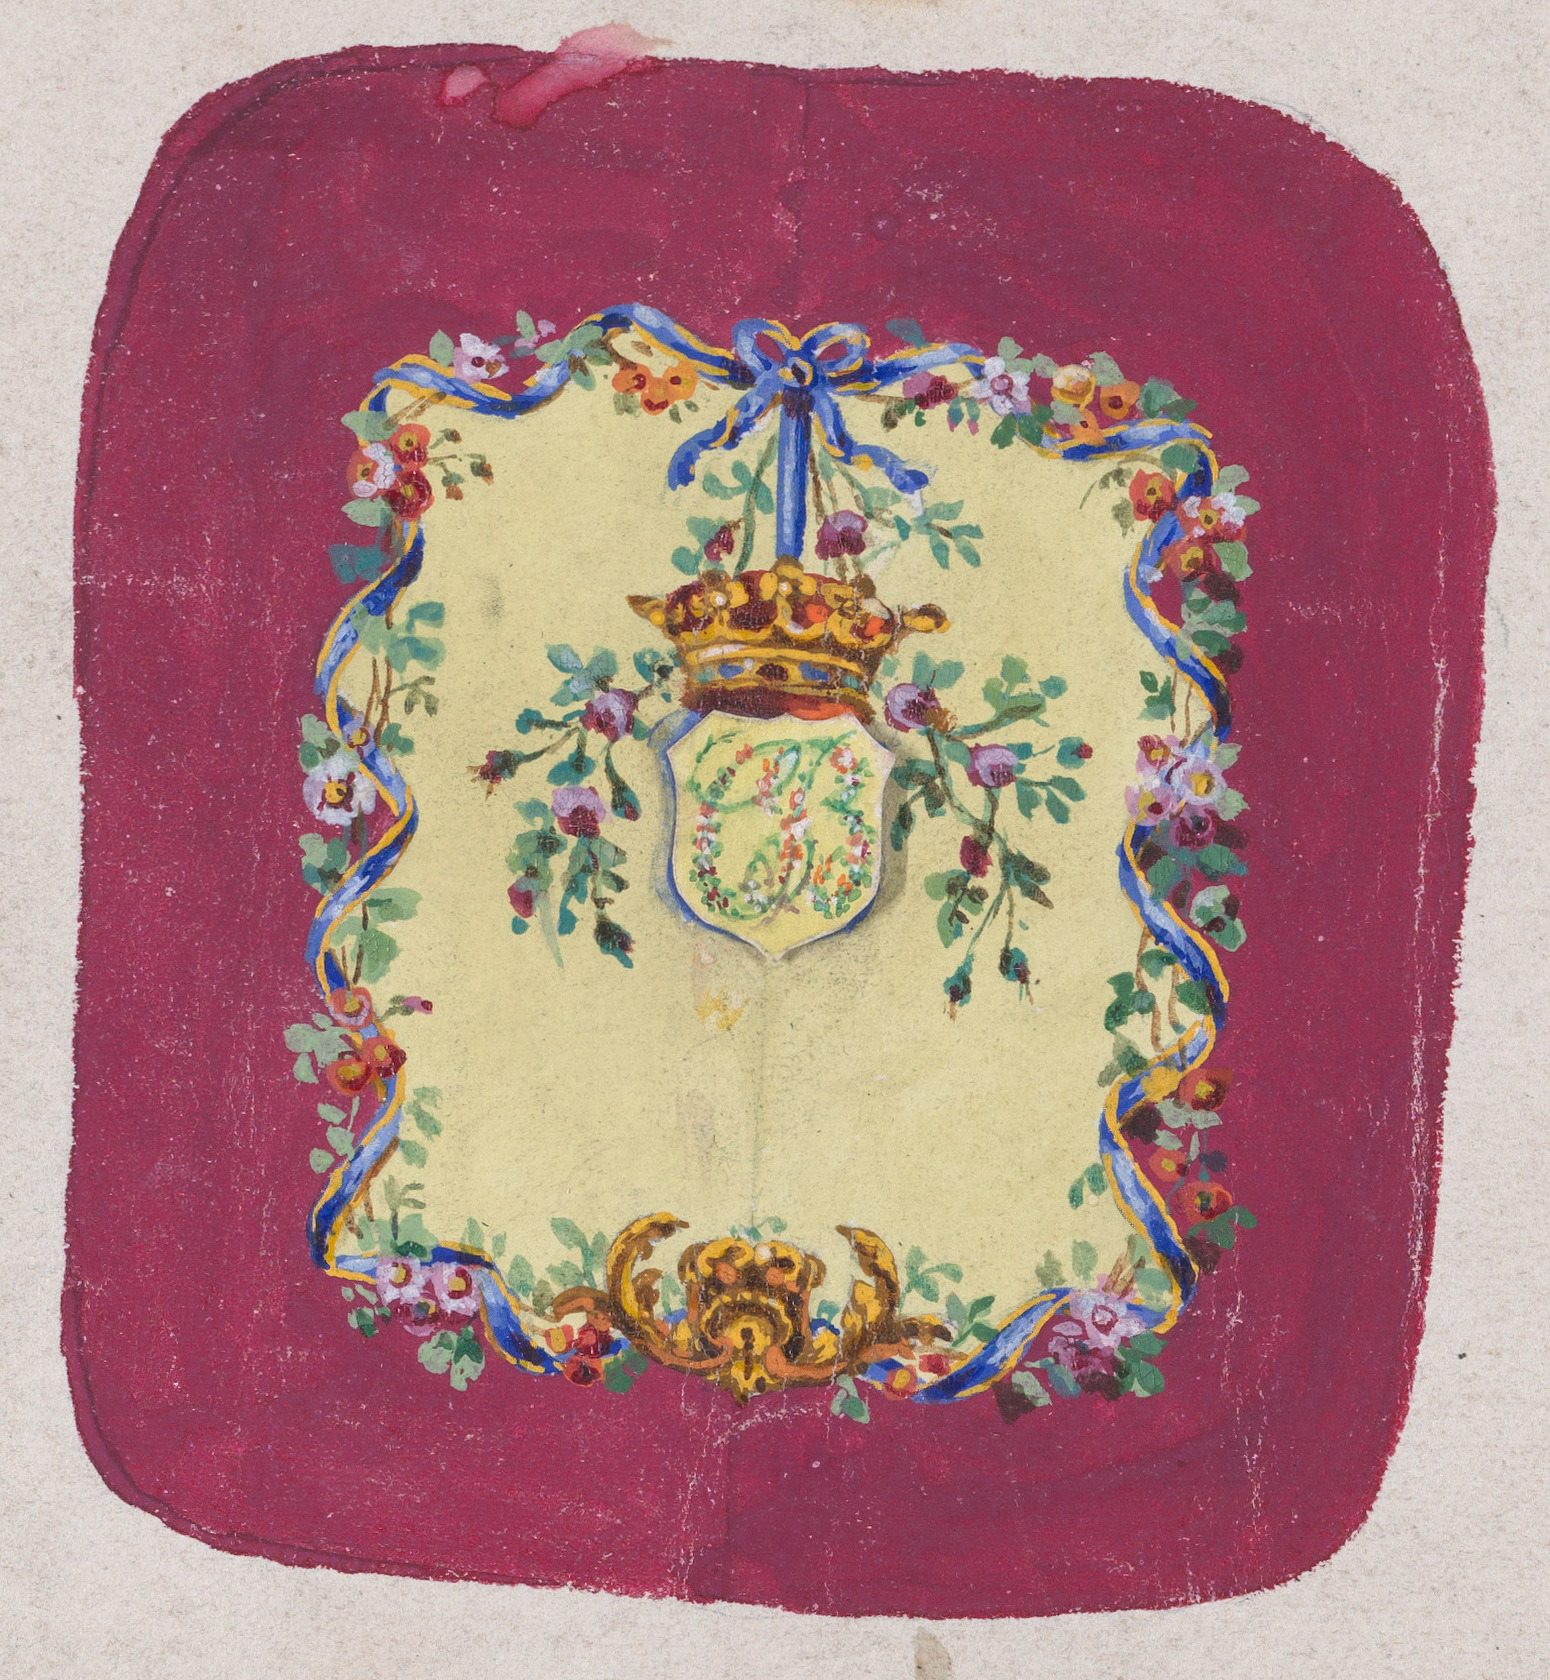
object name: drawing ornament architecture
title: Design for a Chair Back Cover with an Ornamental Frame Formed by a Garland of Leaves and Flowers with an Interlacing Ribbon that Forms a Bow from which a Crown Motif with Monogram Hangs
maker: anonymous, french, 19th century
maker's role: designer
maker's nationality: french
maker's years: 1800-1900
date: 1870-1900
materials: watercolor